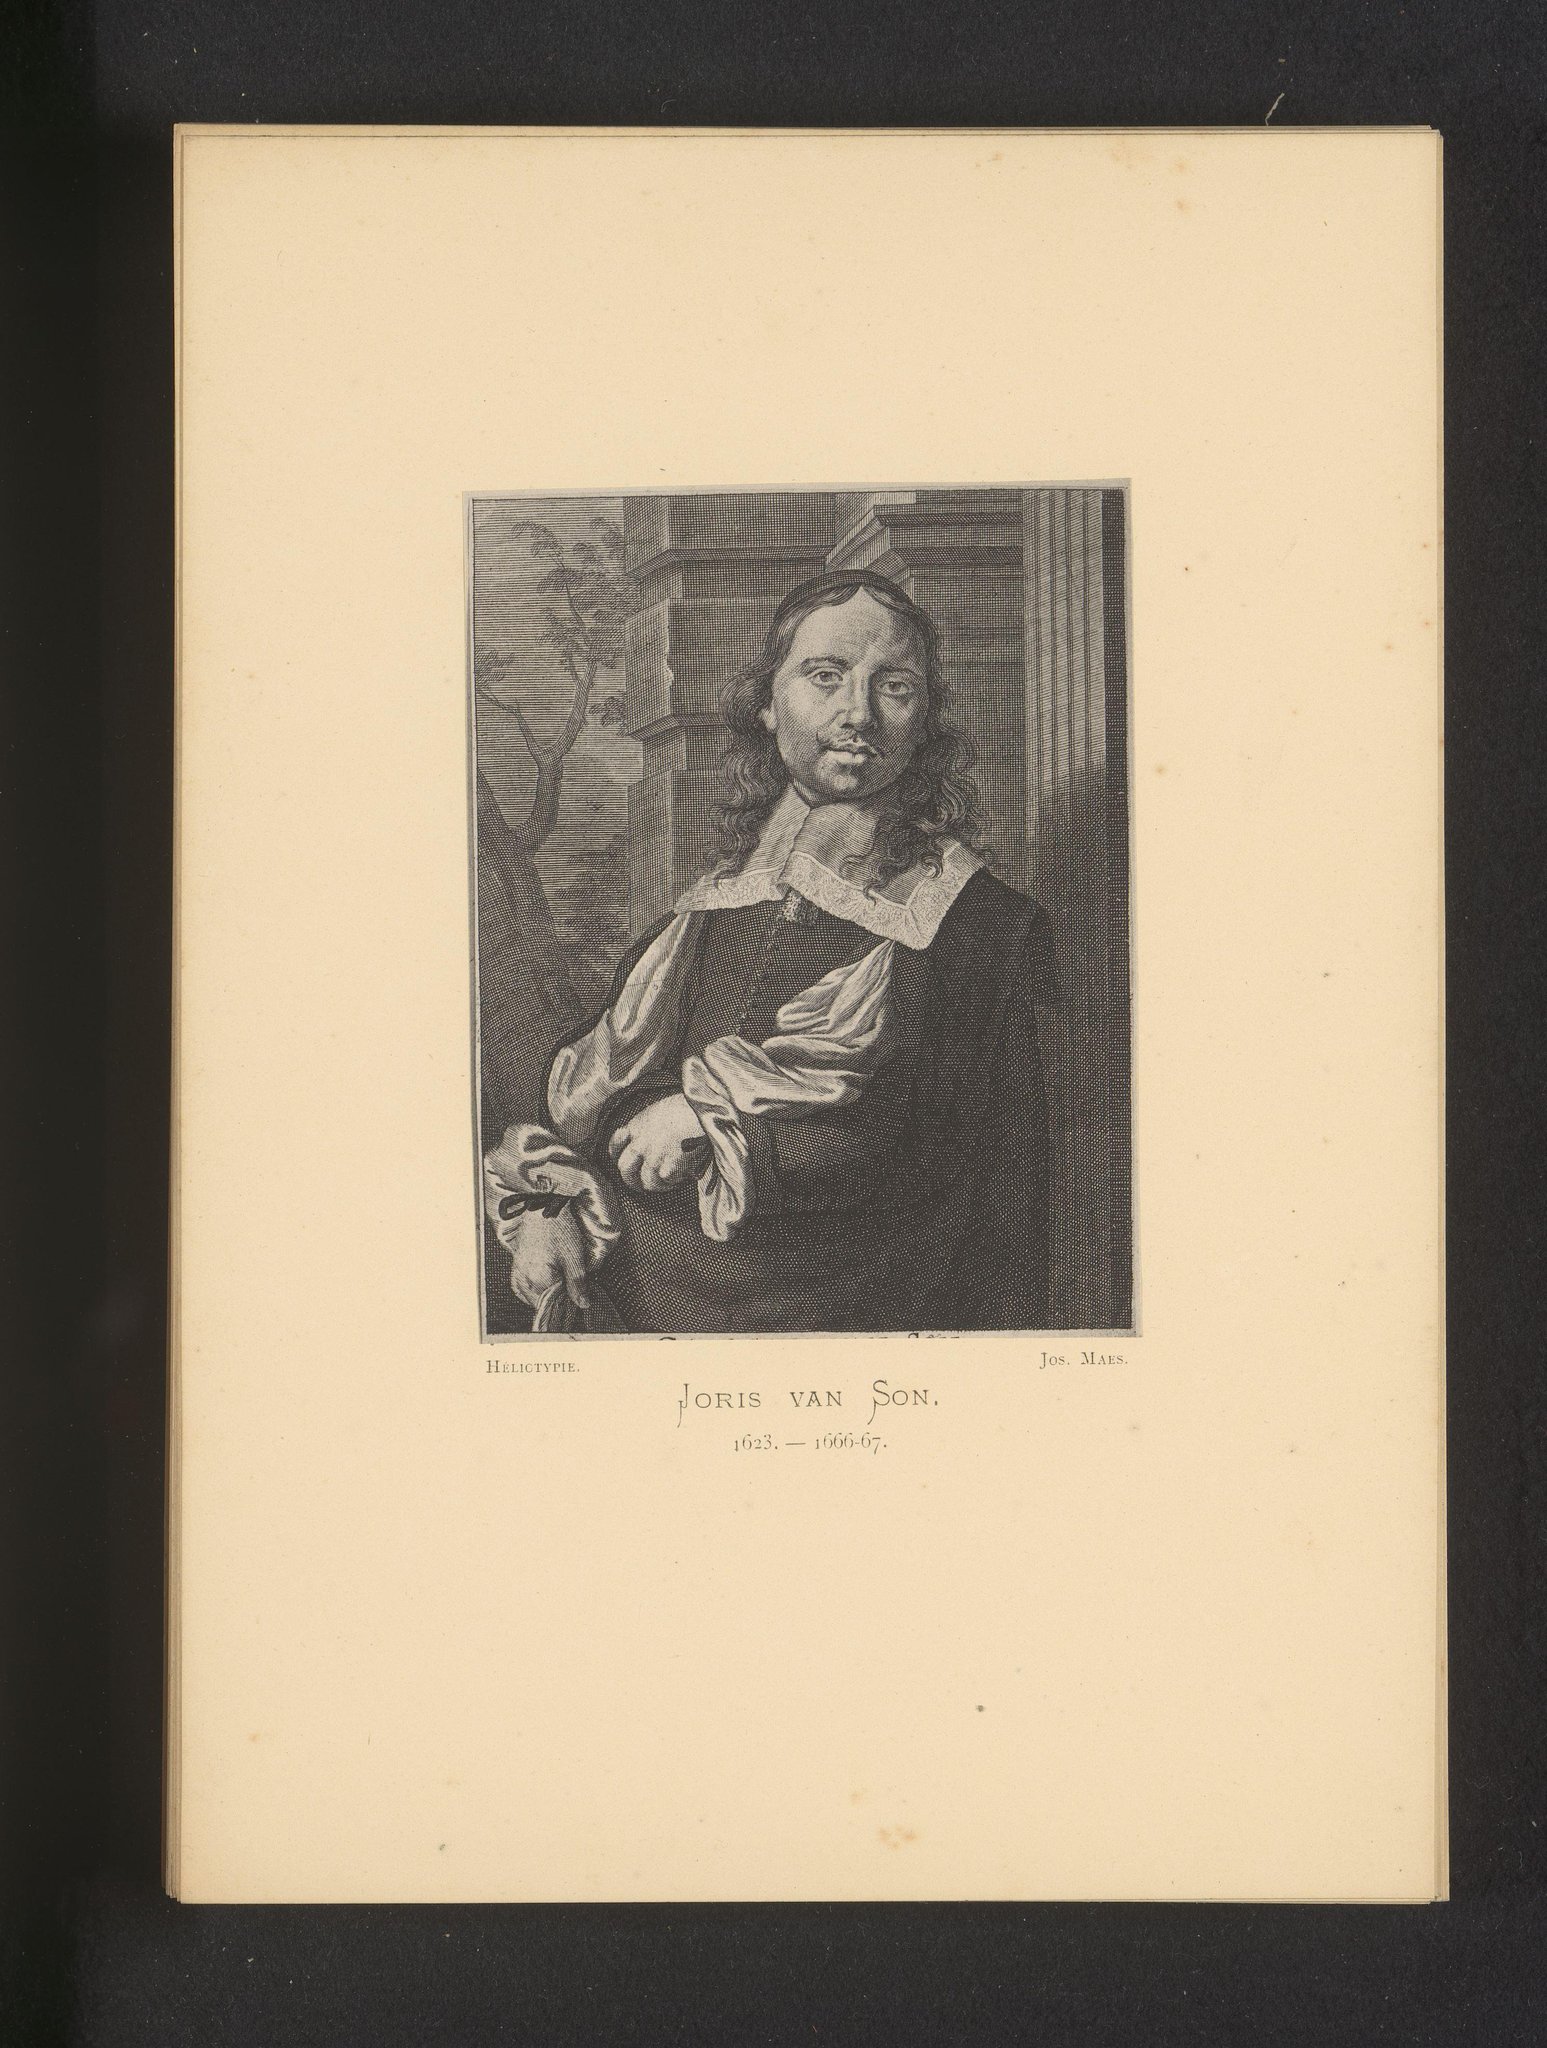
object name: reproduction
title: Joris van Son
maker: joseph maes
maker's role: fotograaf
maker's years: 1838-1908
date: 1872-1877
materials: cardboard, paper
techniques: photograph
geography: antwerp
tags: painter, joris van son, historical persons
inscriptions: inscription: ‘1623. - 1666-67.’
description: Deze prent maakt deel uit van een omslag met 150 prenten en een katern met een lijst van afbeeldingen.